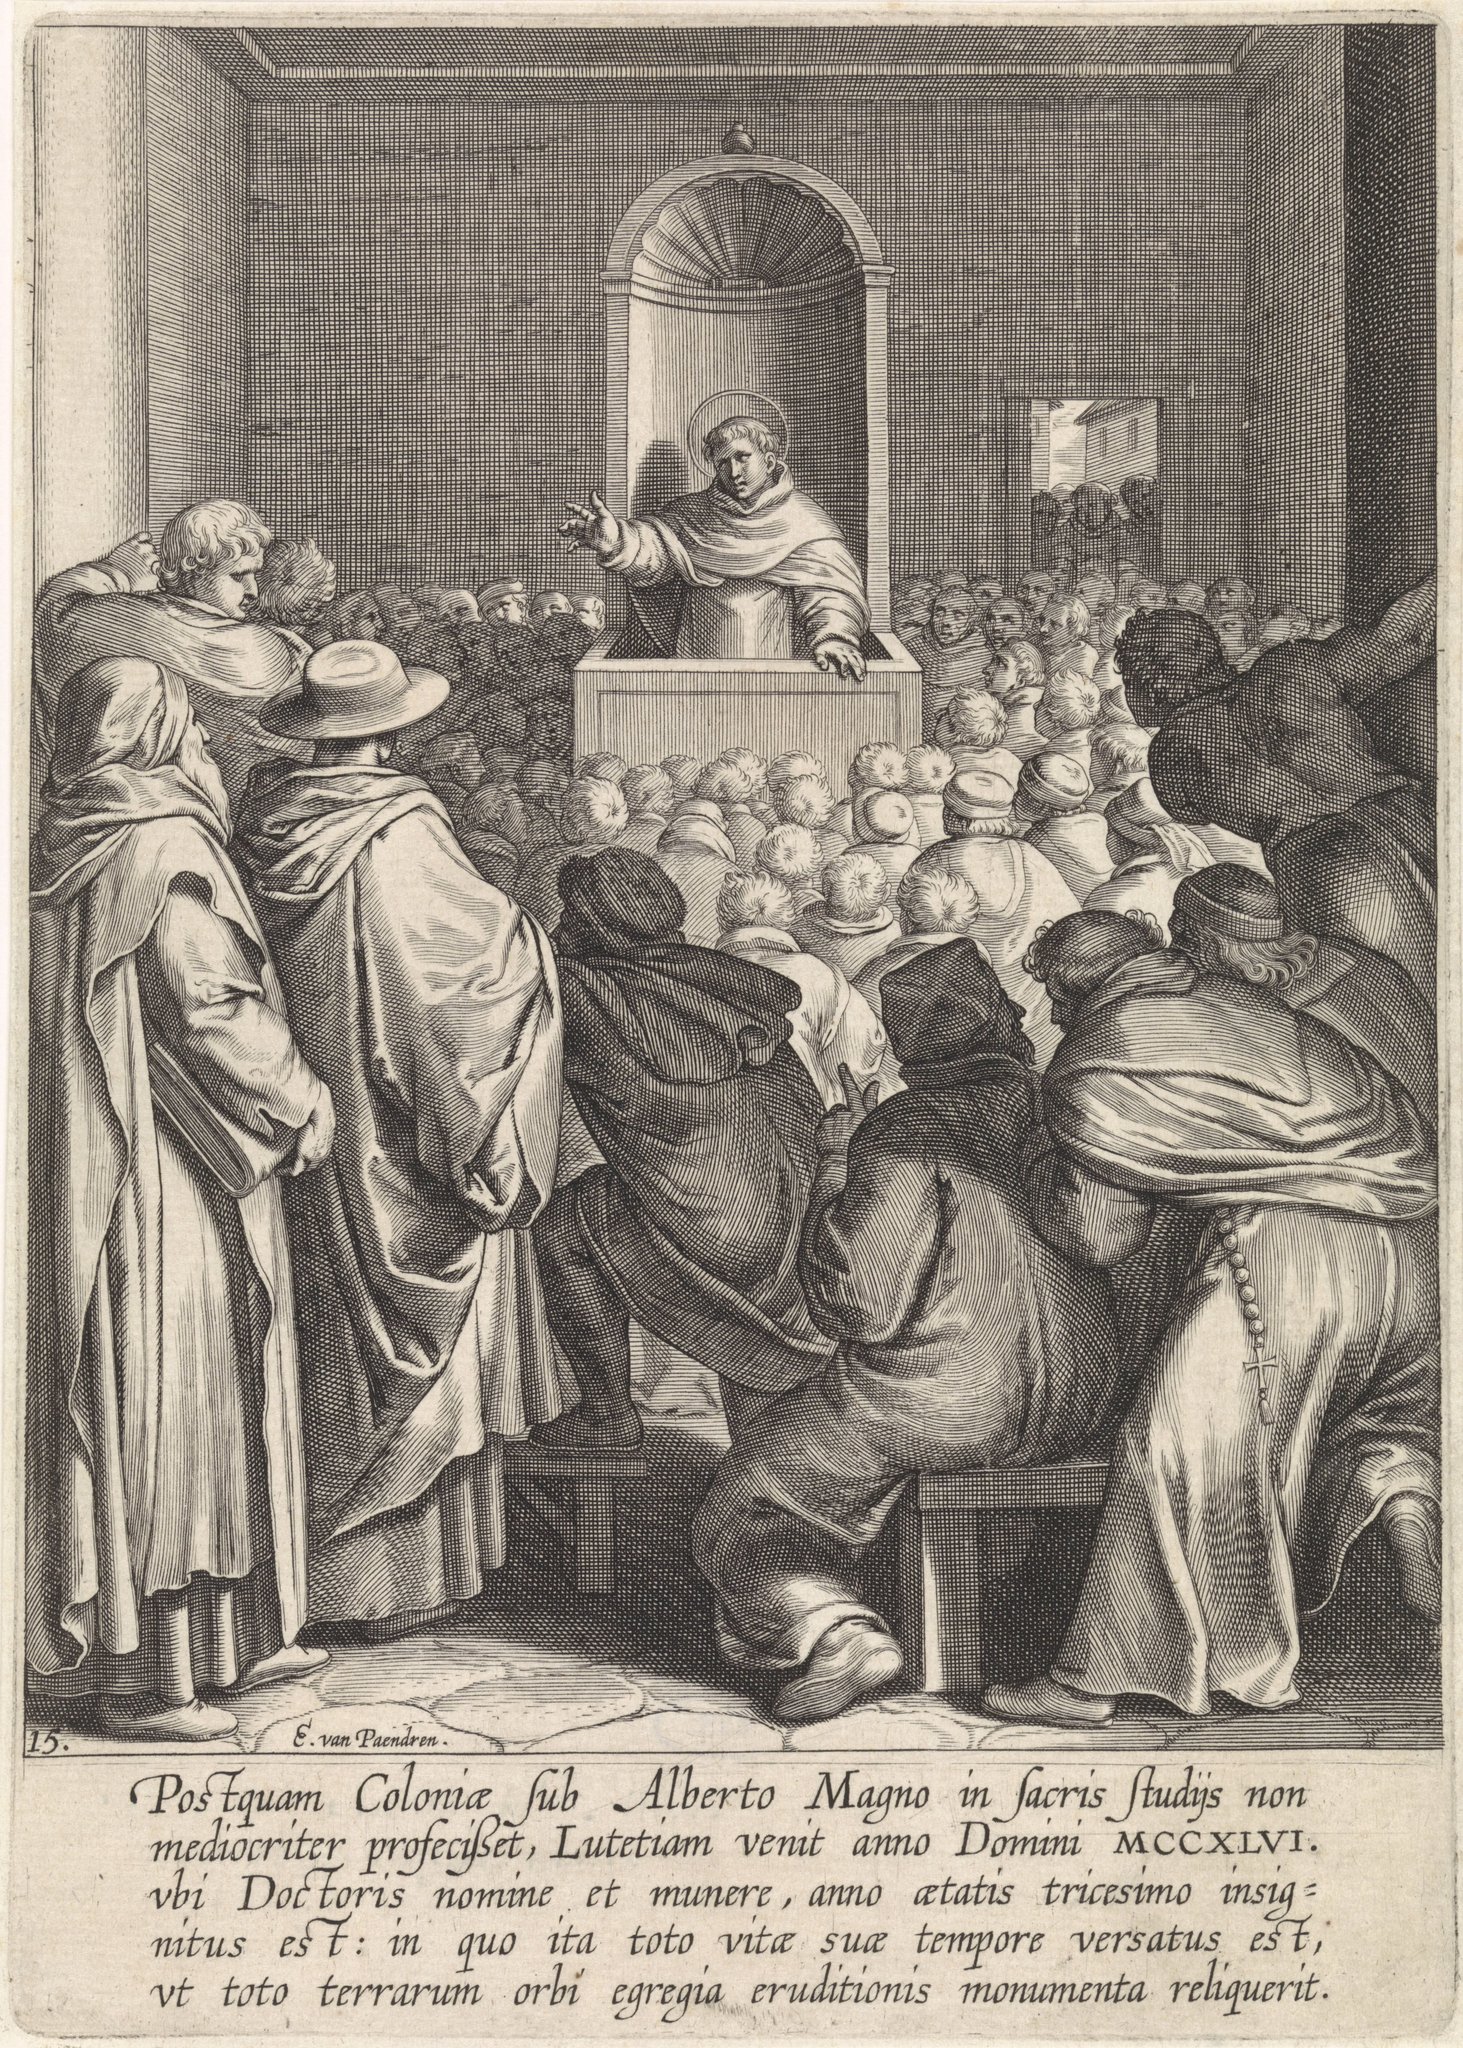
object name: print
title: Preek van Thomas van Aquino in Parijs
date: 1610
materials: paper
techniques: engraving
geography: antwerp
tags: cologne, the dominican theologian, 'angelic doctor' thomas of aquino; possible attributes: book, (chain with) sun, dove, girdle of chastity, lily, model of church, monstrance (or chalice), mitre (under feet), star (on breast) - early life of male saint, paris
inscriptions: collector's mark: Lugt 2228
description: Thomas van Aquino houdt een preek in Parijs, waar hij in 1246 naar toe werd gestuurd en leerling werd van de Duitse filosoof Albertus Magnus. Thomas van Aquino preekt voor een grote groep monniken. In de marge een vijfregelig onderschrift in het Latijn. Vijftiende prent uit een serie van dertig prenten die het levensverhaal van Thomas van Aquino verbeelden.